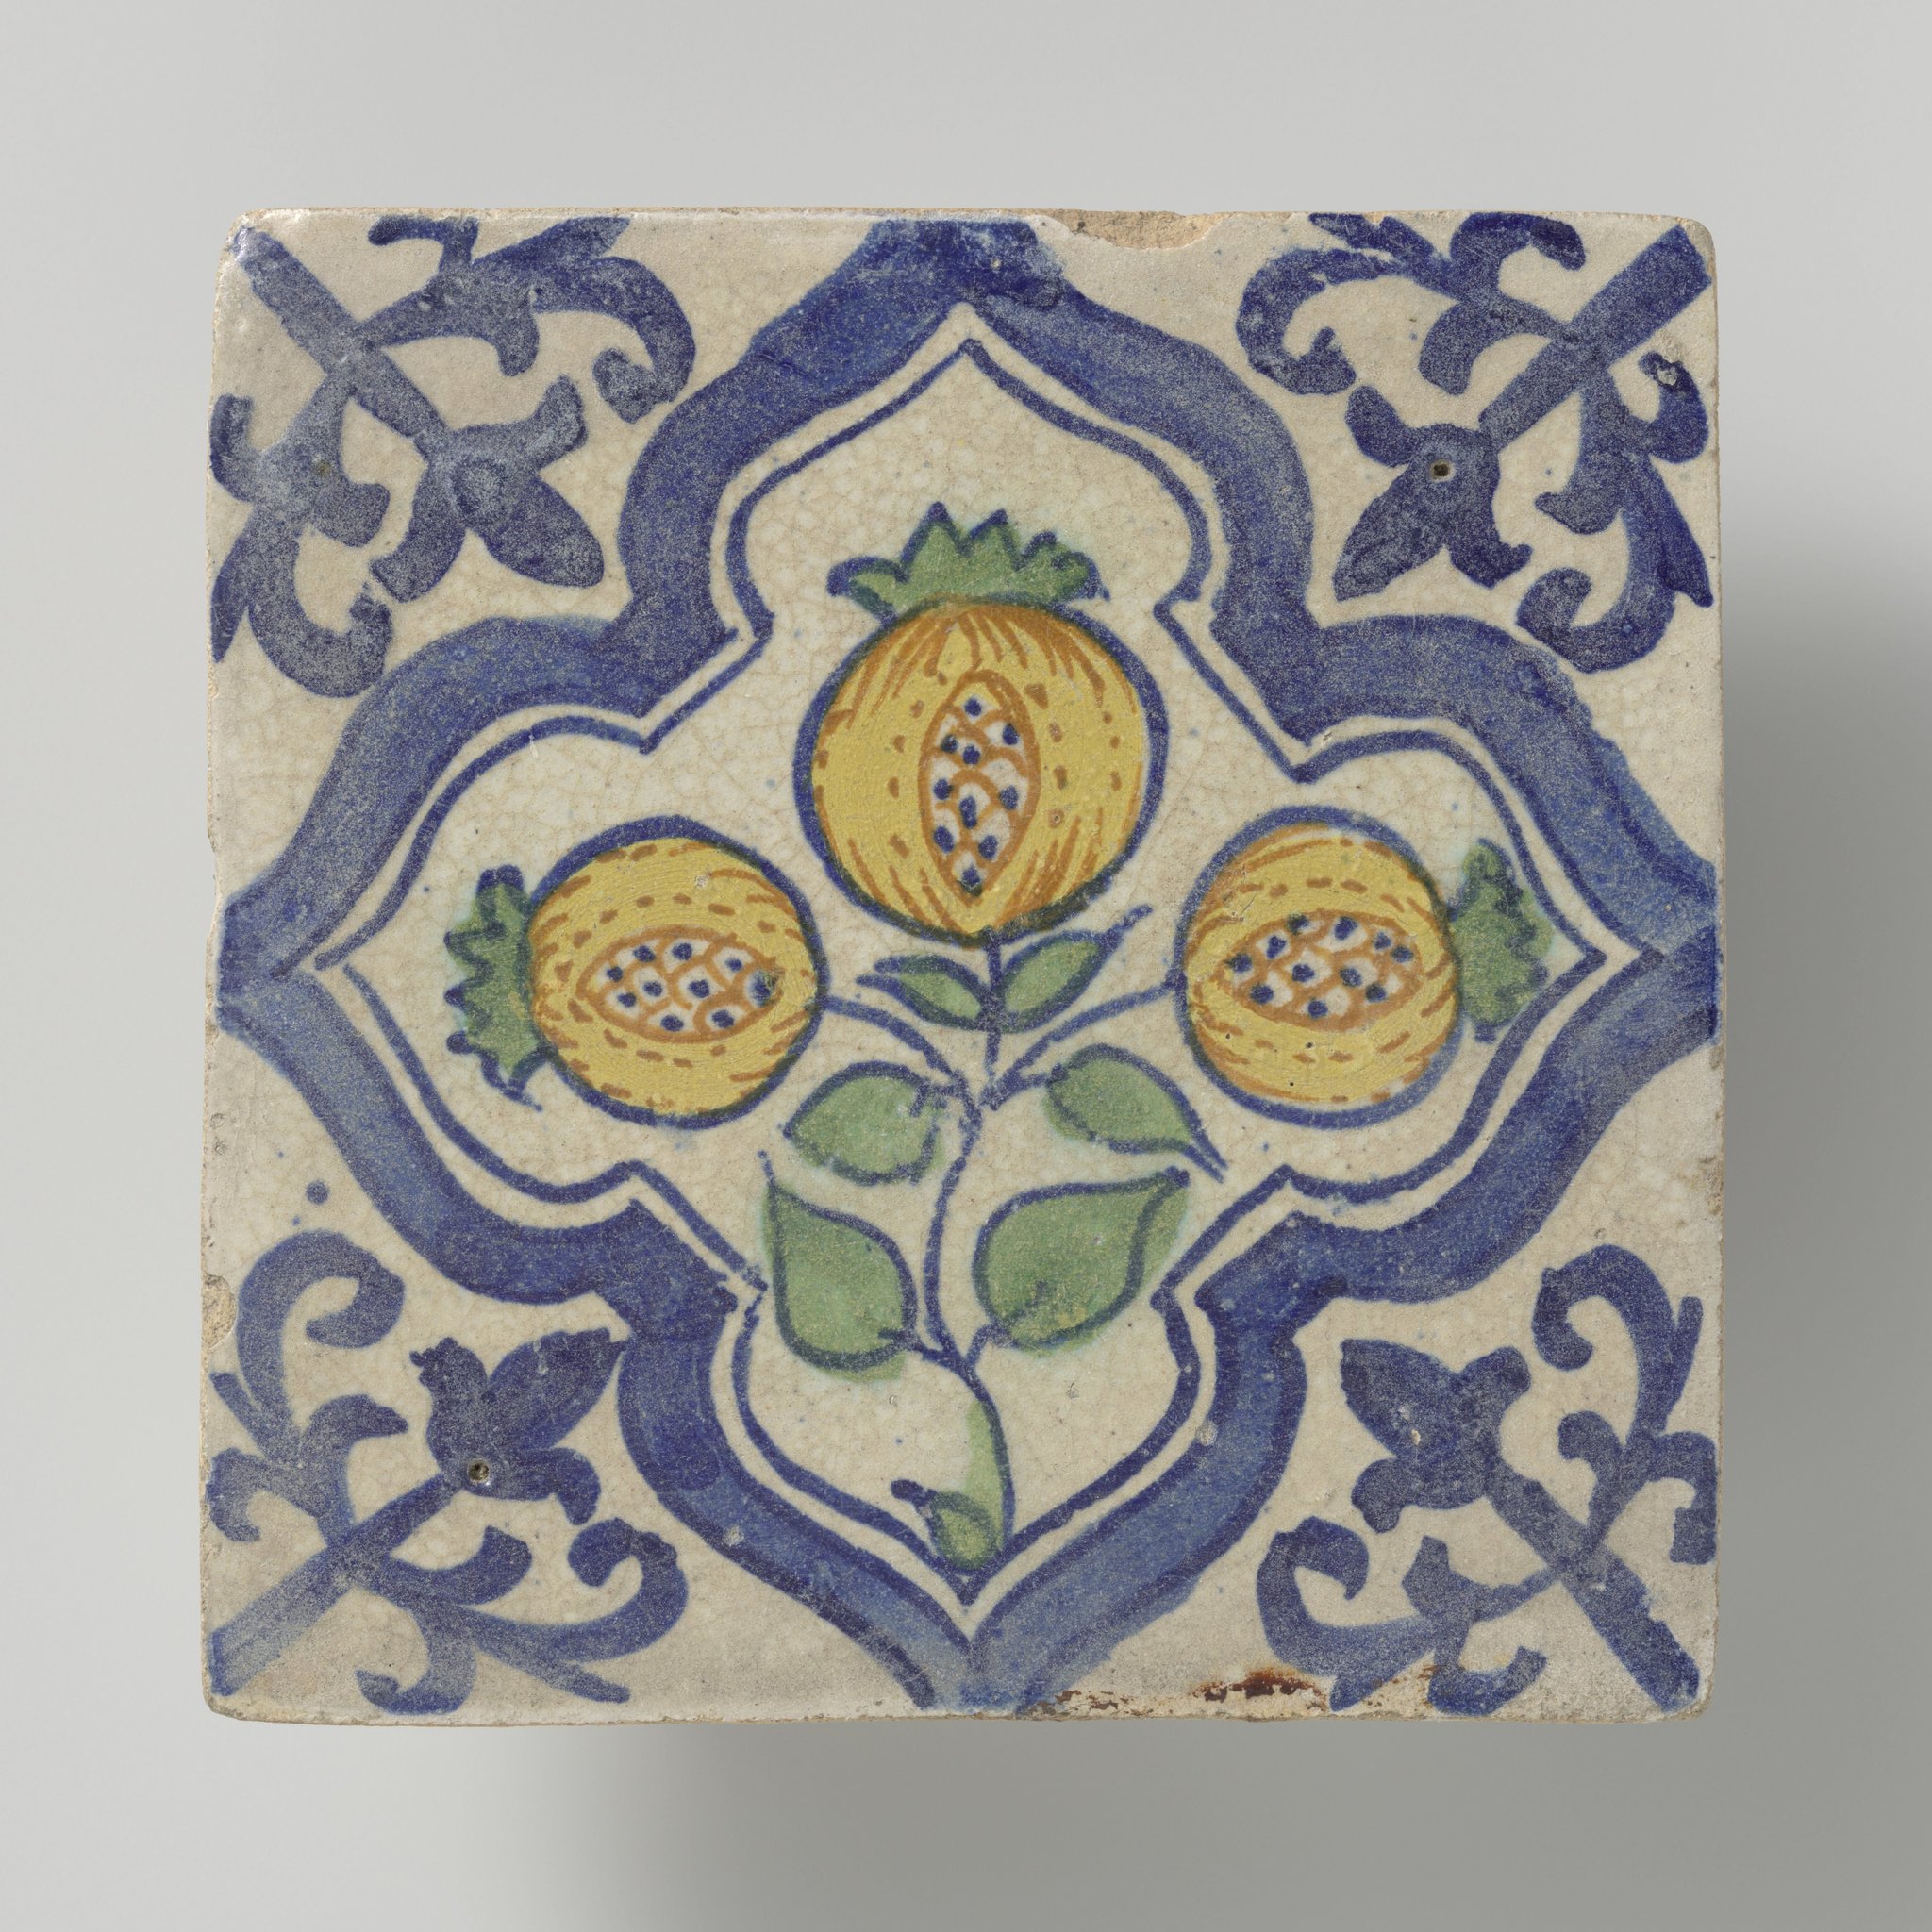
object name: tile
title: Tegel met granaatappels in vierpas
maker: Anonymous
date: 1640-1660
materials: earthenware, glaze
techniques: maiolica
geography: netherlands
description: Tegel met veelkleurige (blauw, oranje, groen en geel) geschilderde granaatappels binnen een vierpas. In de hoeken, een vleugelblad.